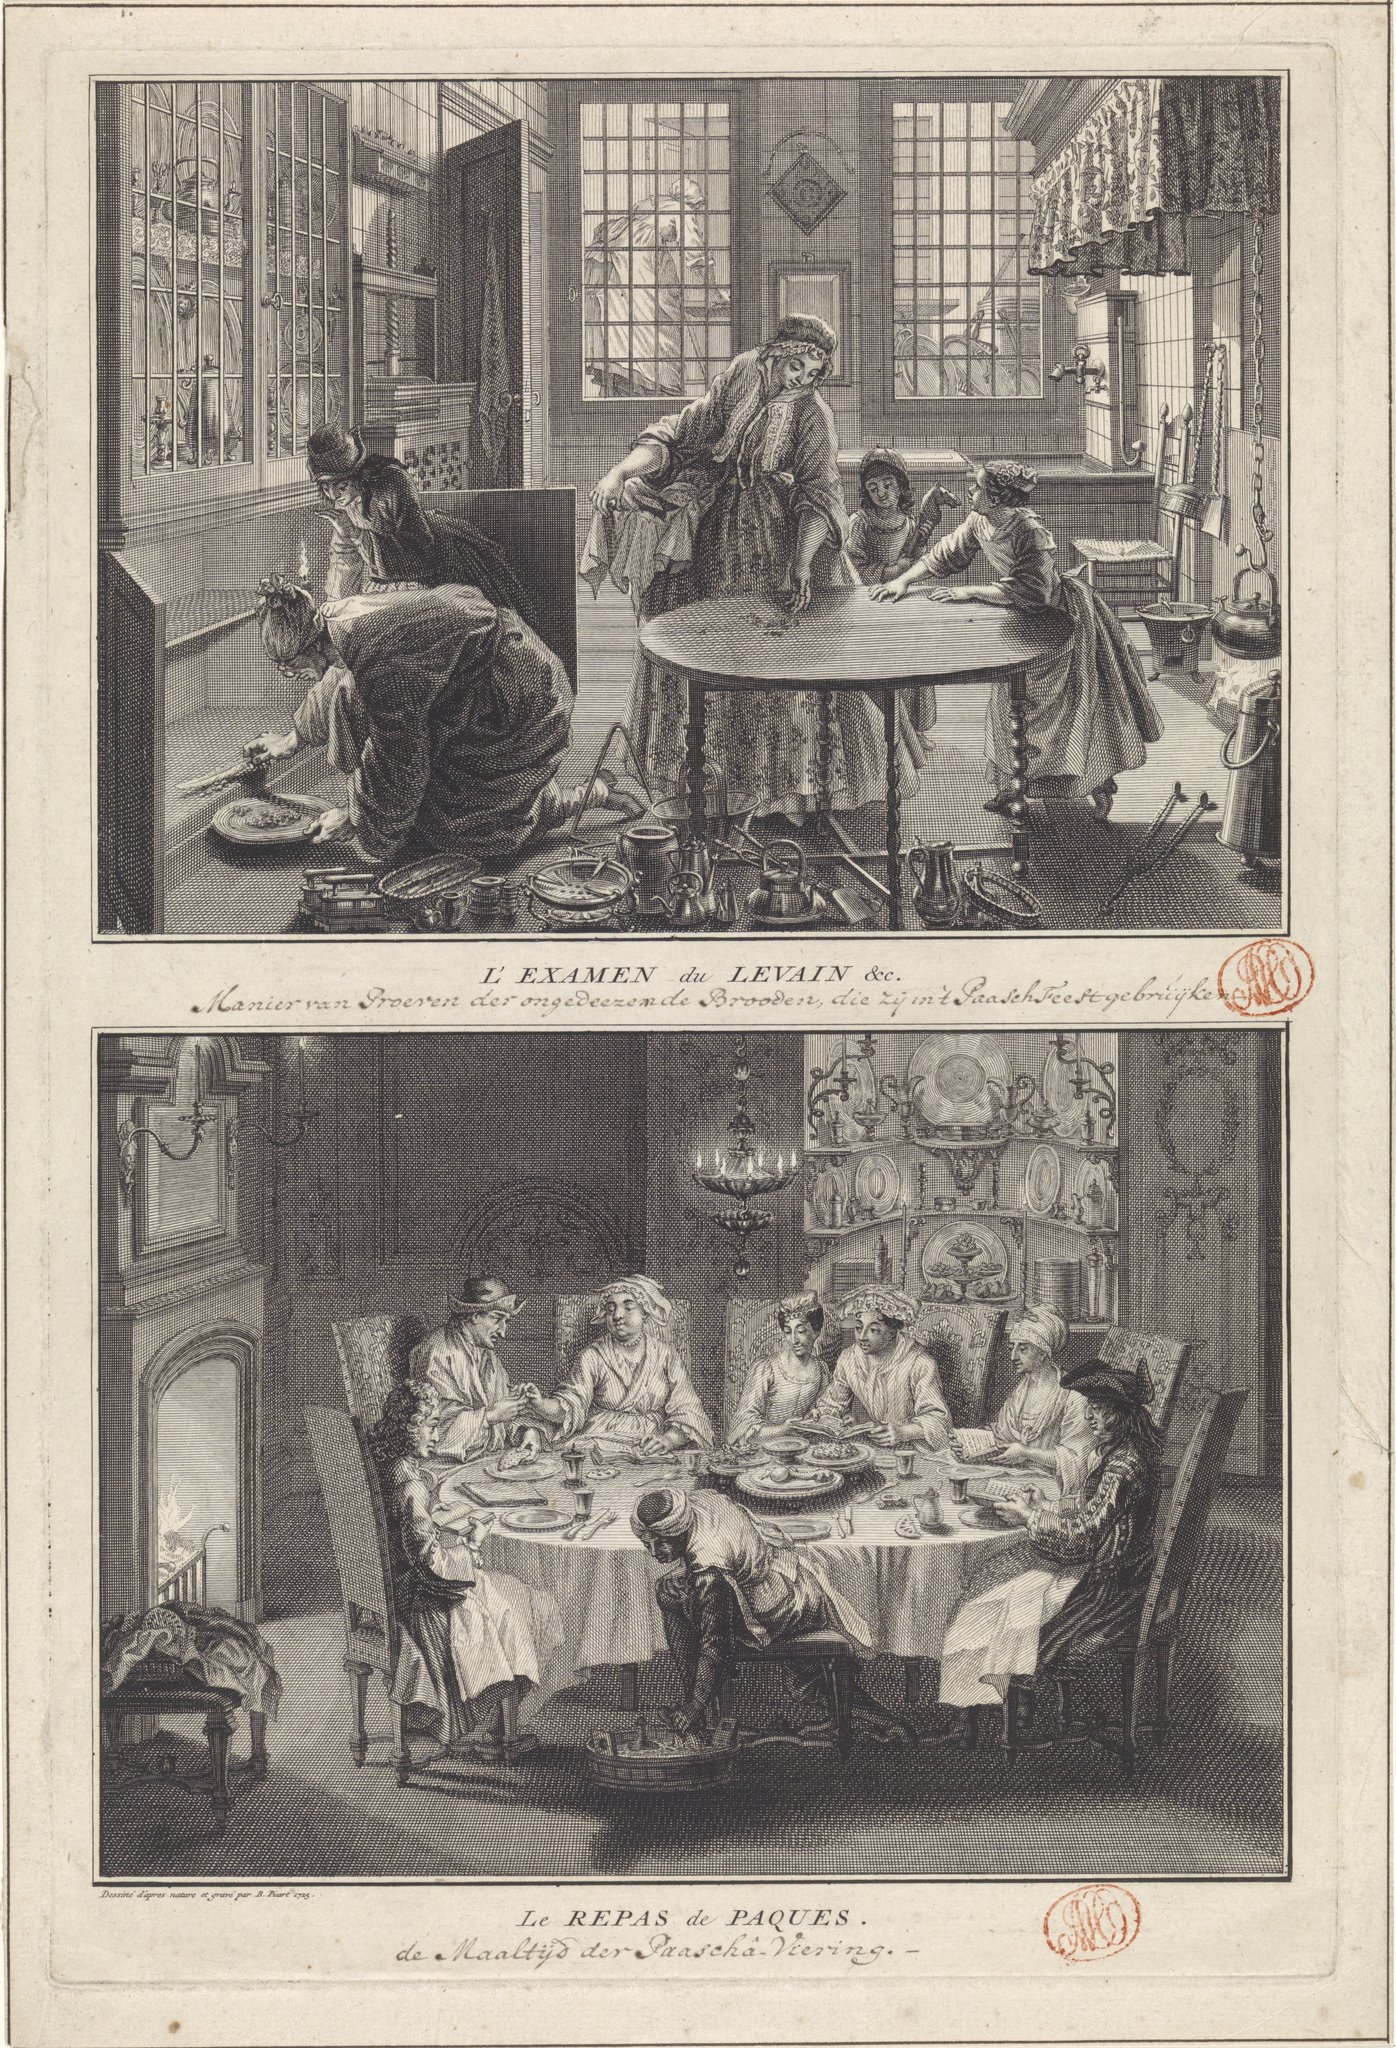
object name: book illustration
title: L'Examen du Levain &c / Le Repas de Pasques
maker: bernard picart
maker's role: draughtsman, print maker, publisher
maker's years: 1673-1733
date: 1725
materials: paper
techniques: engraving, etching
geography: amsterdam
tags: 'seder' (home service for 'pesah'), 'haggadah' (the book used in the 'seder'), searching for leaven ~ preparations for 'pesah'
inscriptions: inscription: ‘Manier van Proeven der ongedeezemde Brooden, die zij in 't PaaschFeest gebruijken. / de Maaltijd der Paaschâ-Viering.-’, collector's mark: Lugt 2233, collector's mark: Lugt 195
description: Blad met twee voorstellingen van joodse gebruiken rond de viering van het Pesach. Boven: Een echtpaar speurt in hun huis naar kruimels brood, die zuurdesem bevatten. De man veegt met een veer kruimels op een bord, terwijl iemand met een kaars hem bijlicht. De vrouw en haar kinderen staan bij tafel, waarop kruimels bijeen zijn gebracht. Het hele huis wordt schoongemaakt en alles wat zuurdesem bevat wordt uit huis verwijderd. Onder: Een familie zit op sederavond aan de Pesachmaaltijd. Een aantal mensen houdt een zogenaamde haggada in de handen, een boek met daarin een samenvatting van de gebeurtenissen voor en na de uittocht uit Egypte.